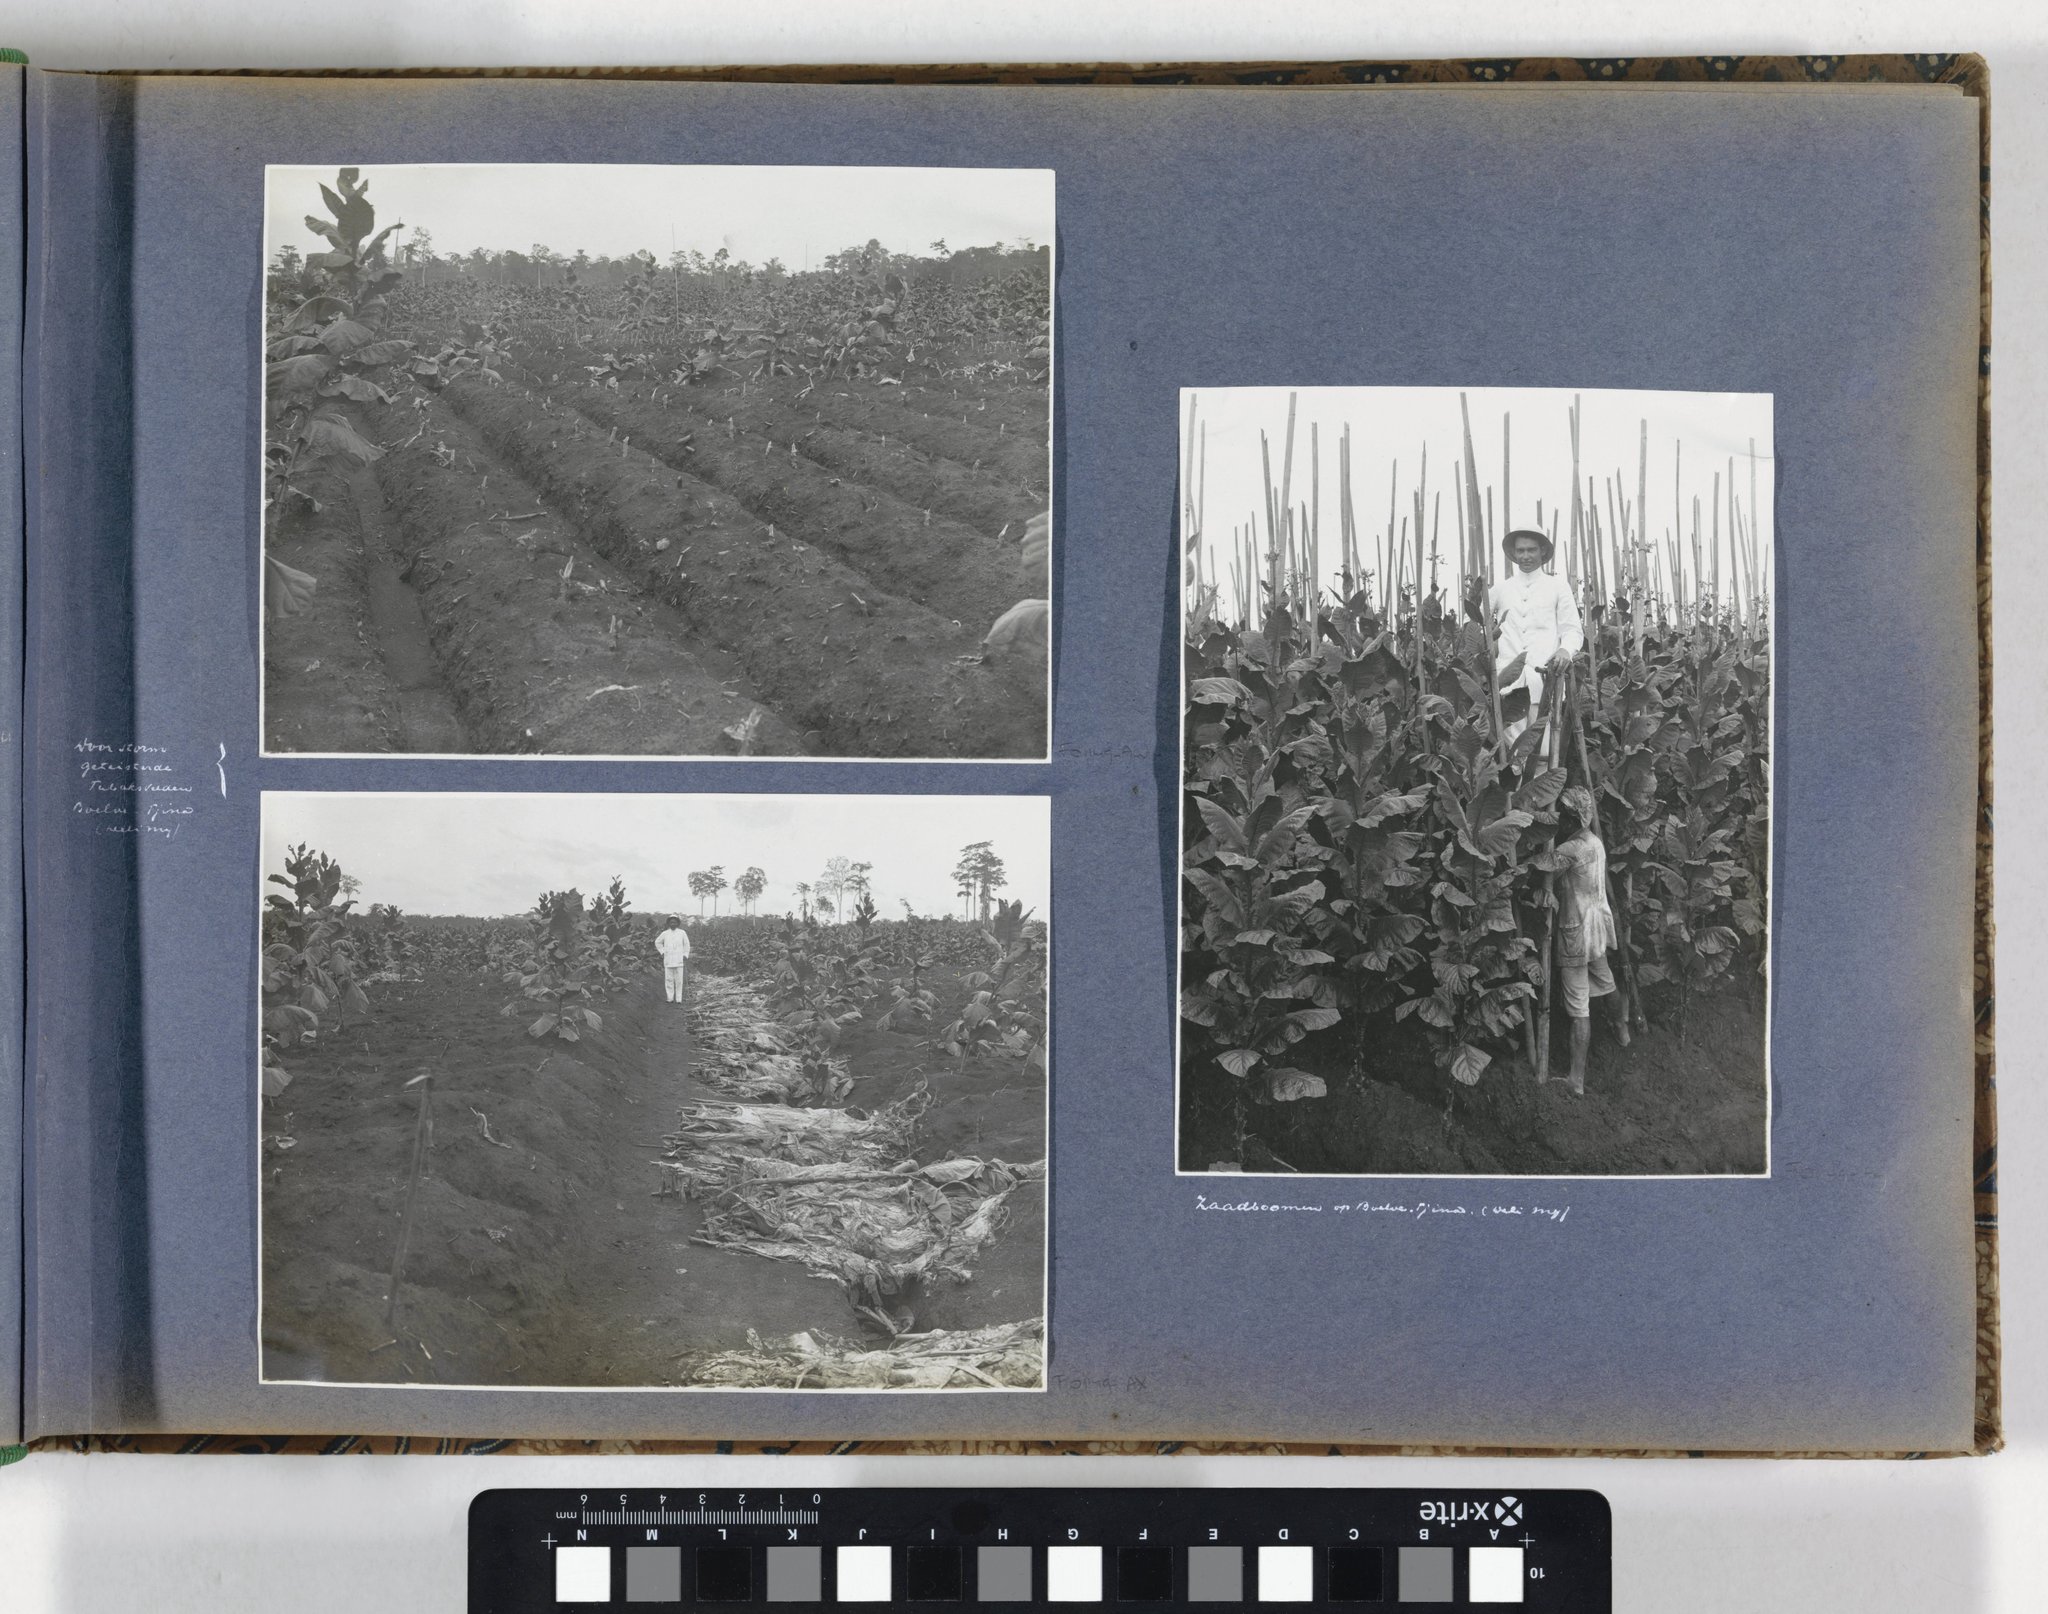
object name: photograph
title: Planter en Indische man tussen zaadbomen van tabaksplantage Boeloe Tjina op Sumatra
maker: Anonymous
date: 1900-1920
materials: paper, photographic support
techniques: gelatin silver print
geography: sumatra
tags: plantation, working class, labourers, tobacco, sumatra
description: Mogelijk gaat het om een contractarbeider. Onderdeel van reisalbum met foto's van bedrijvigheid en bezienswaardigheden op Sumatra en Java en van de reis naar en van Nederlands-Indië.